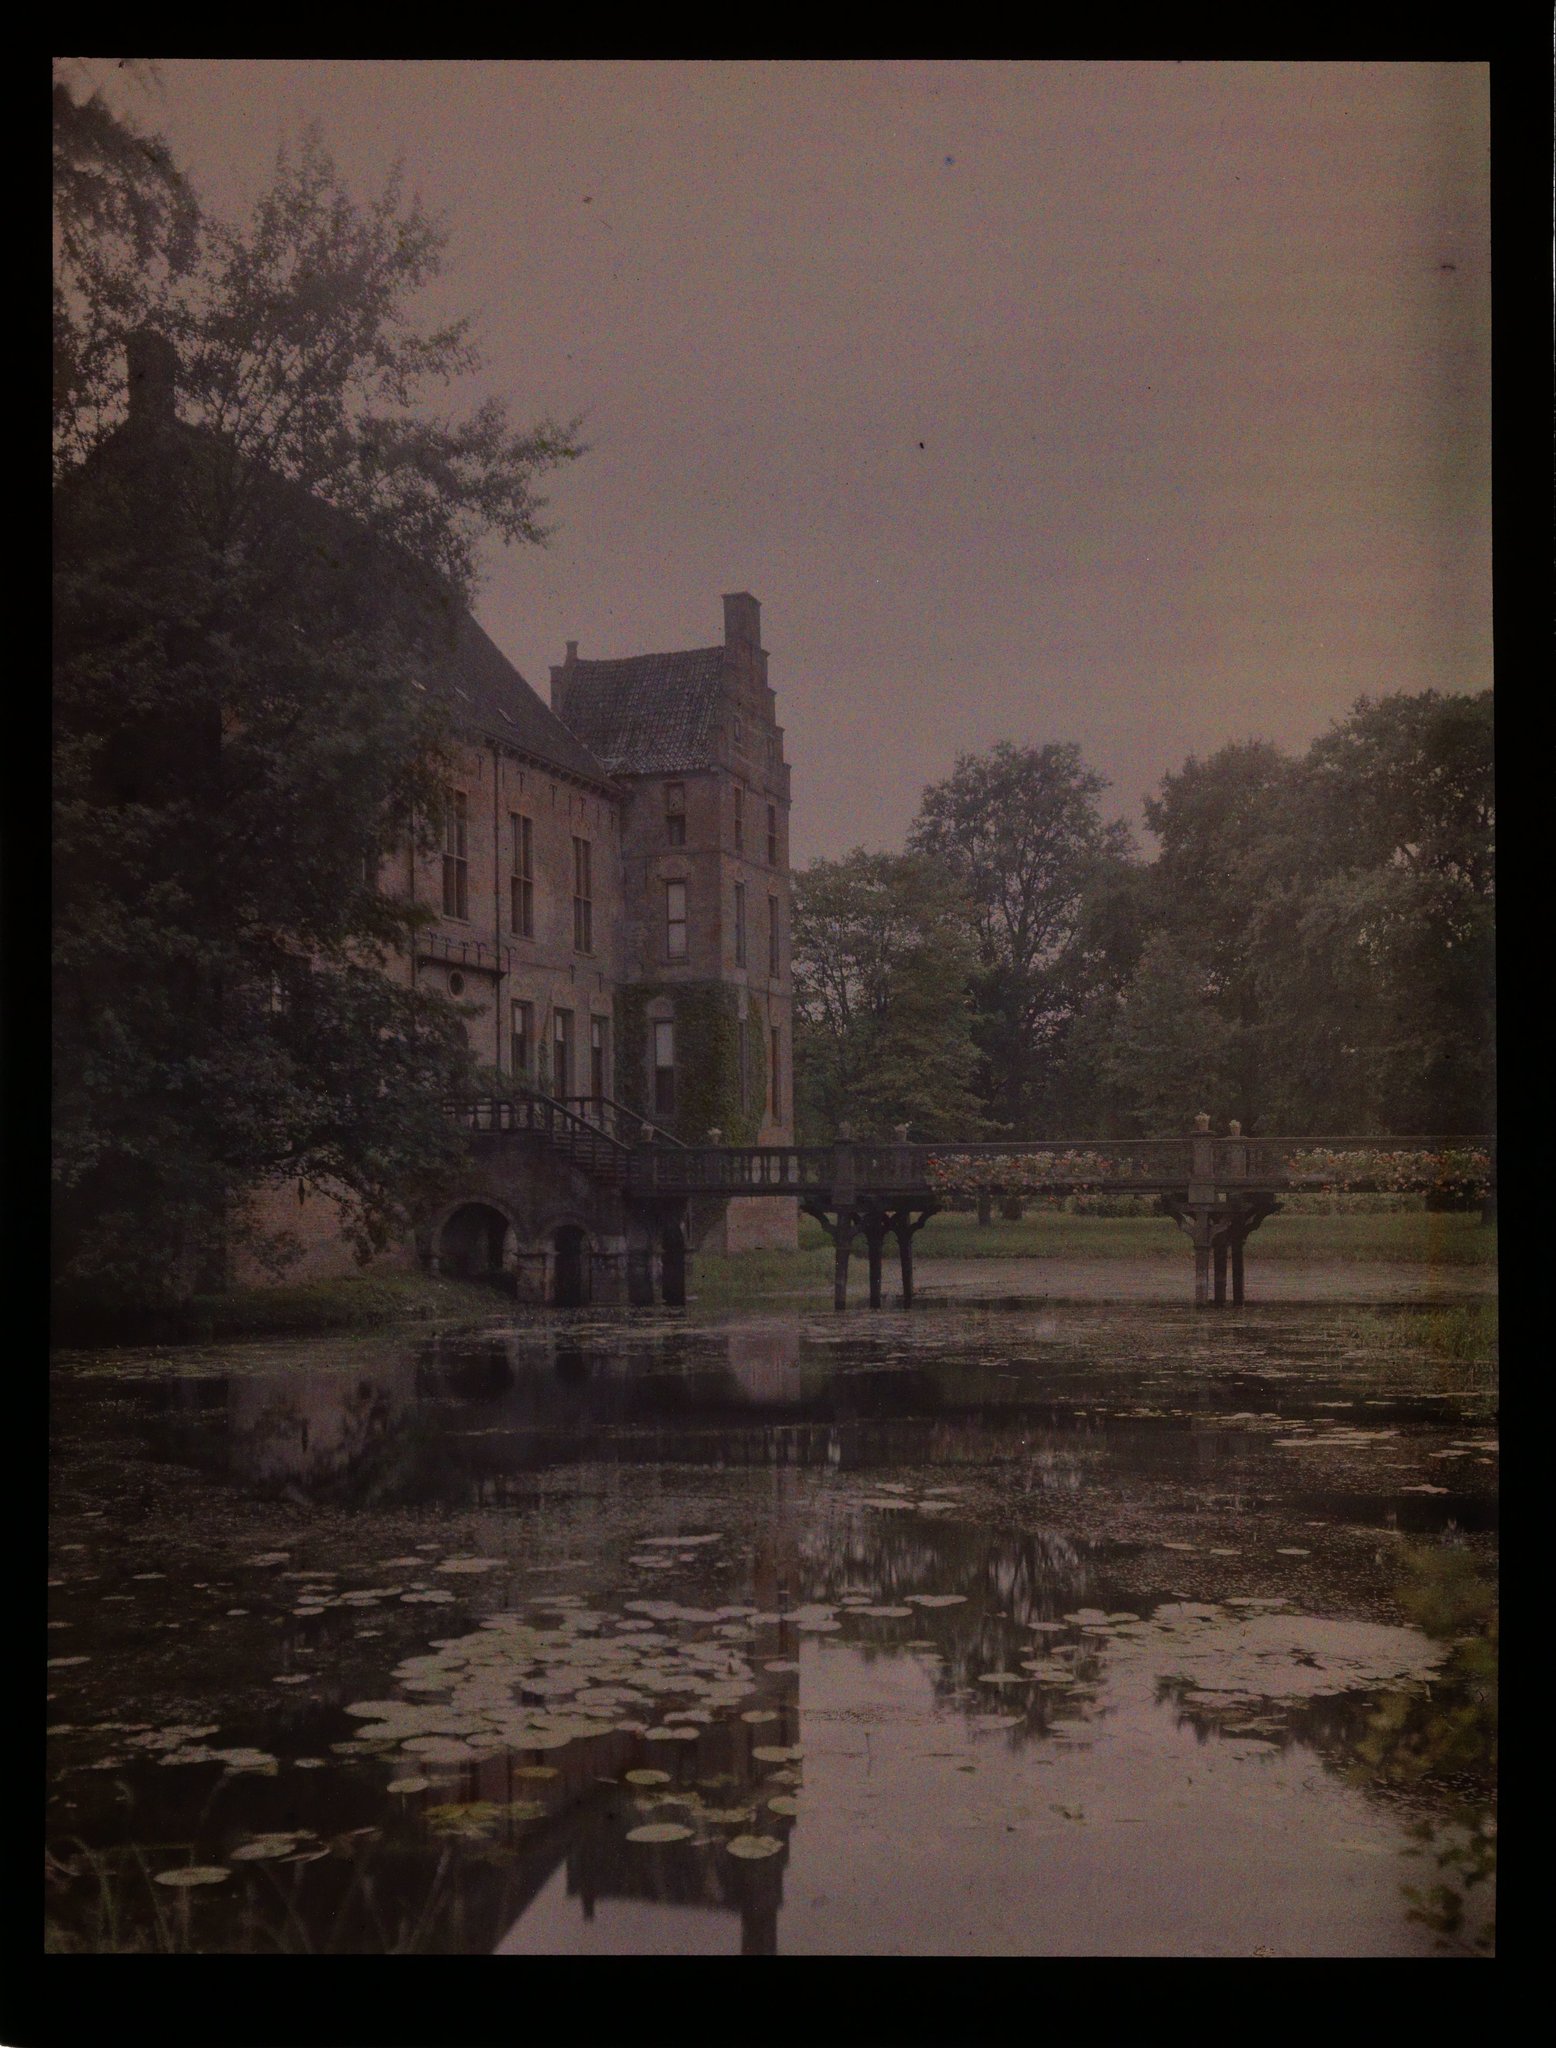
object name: photograph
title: Kasteel met slotgracht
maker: Anonymous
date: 1907-1935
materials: glass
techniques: autochrome process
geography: netherlands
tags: castle, netherlands